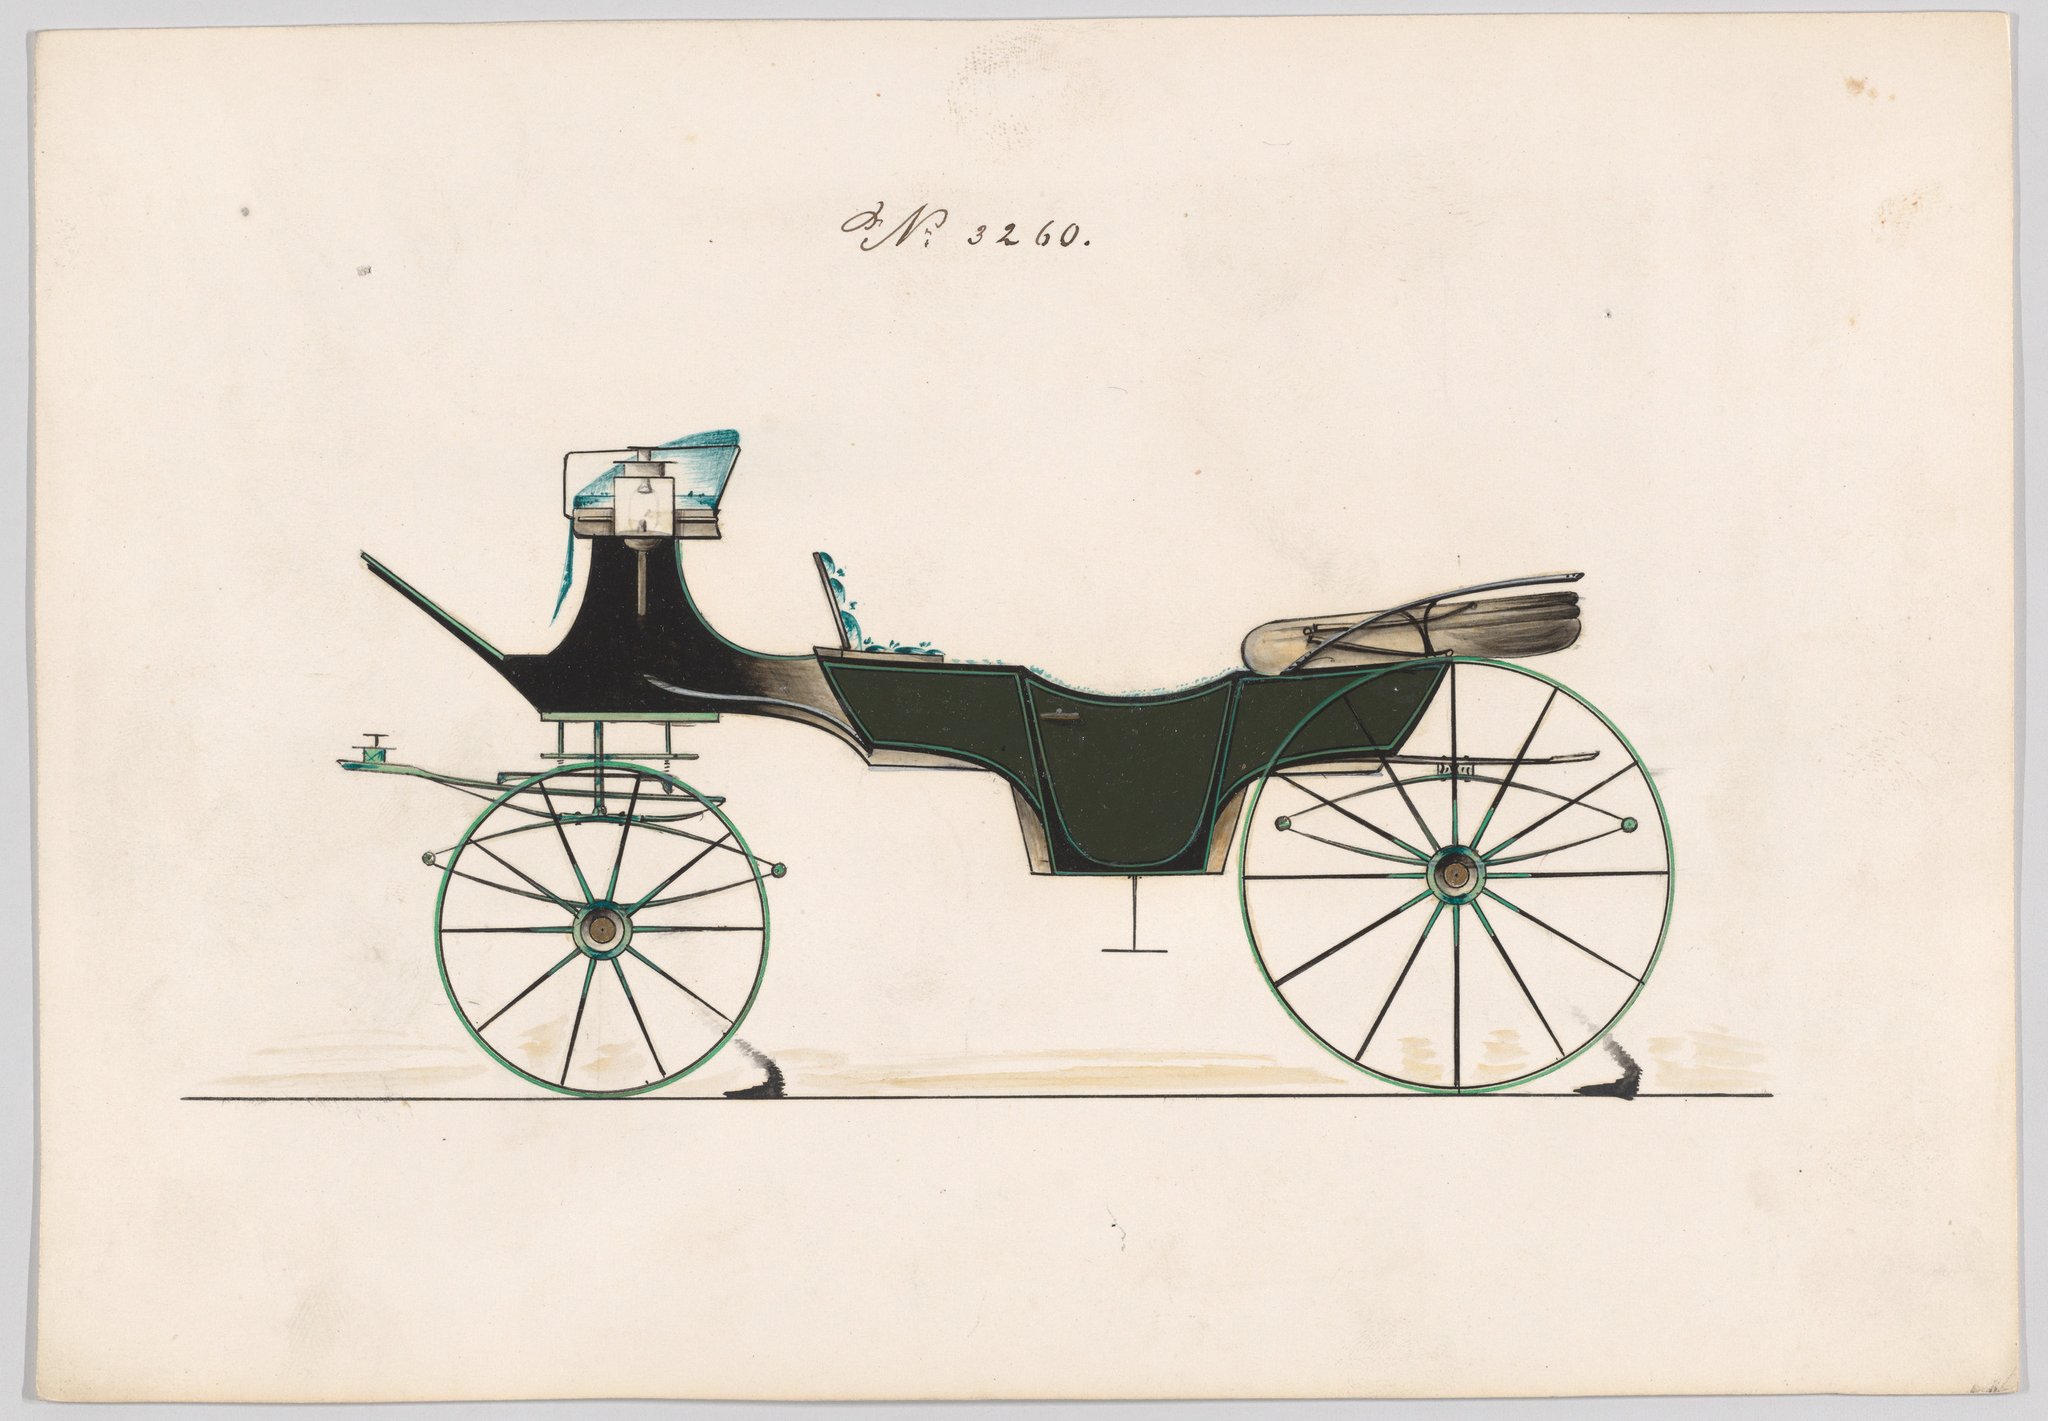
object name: drawing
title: Vis-à-vis/Brett #3260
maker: brewster & co.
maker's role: manufacturer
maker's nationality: american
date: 1876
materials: gouache, gum arabic, ink, watercolor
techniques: pen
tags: carriages